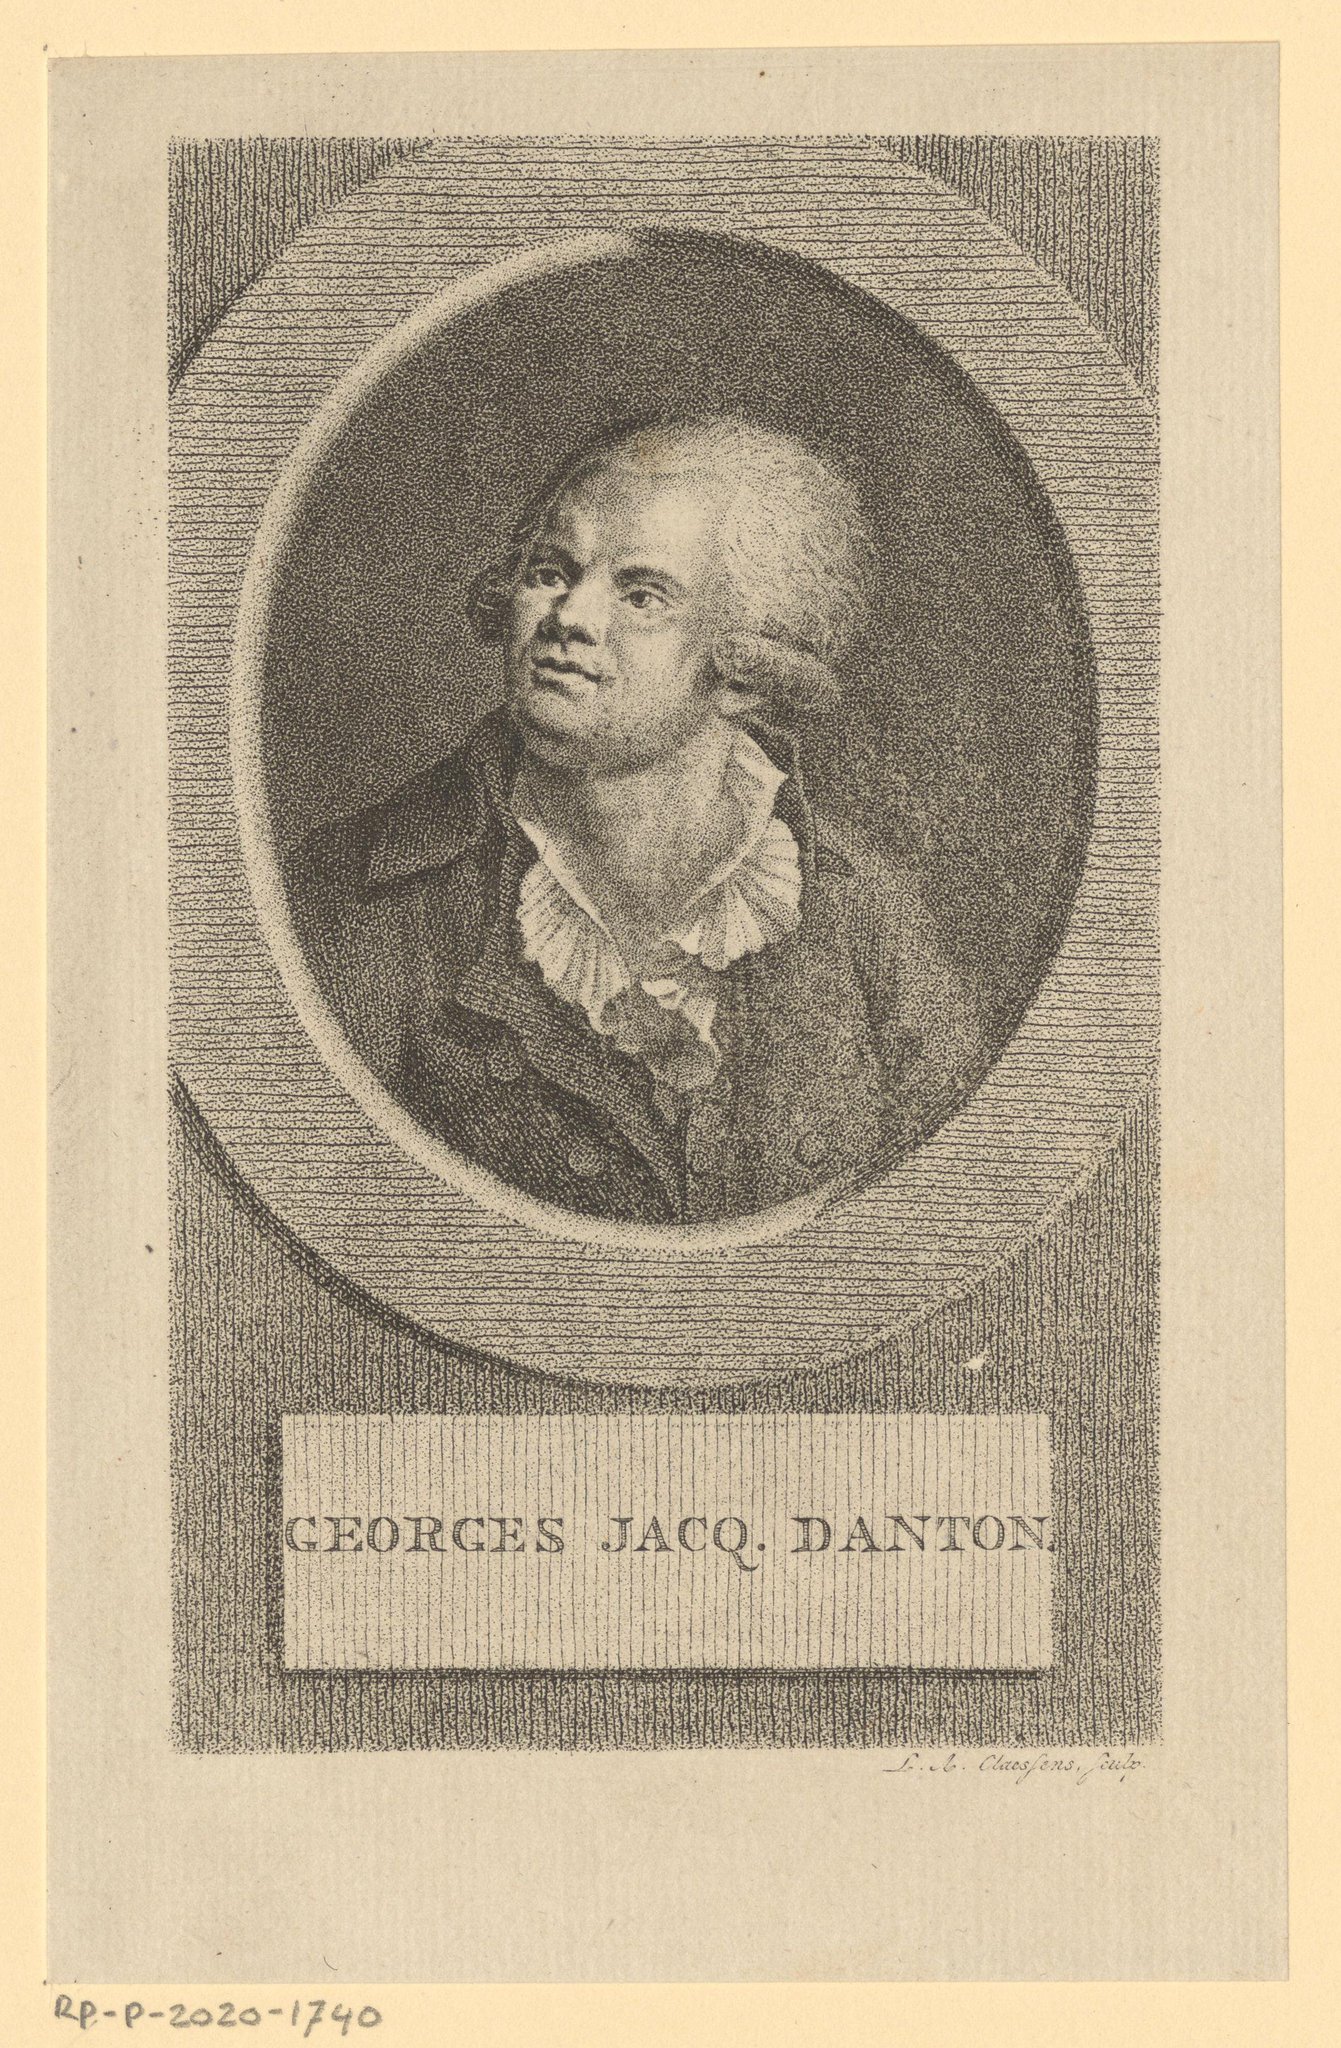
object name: print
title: Portret van Georges-Jacques Danton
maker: lambertus antonius claessens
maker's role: draughtsman, print maker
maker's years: 1763-1834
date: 1792-1843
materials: paper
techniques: engraving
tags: politician, historical persons, patriot (revolutionary)